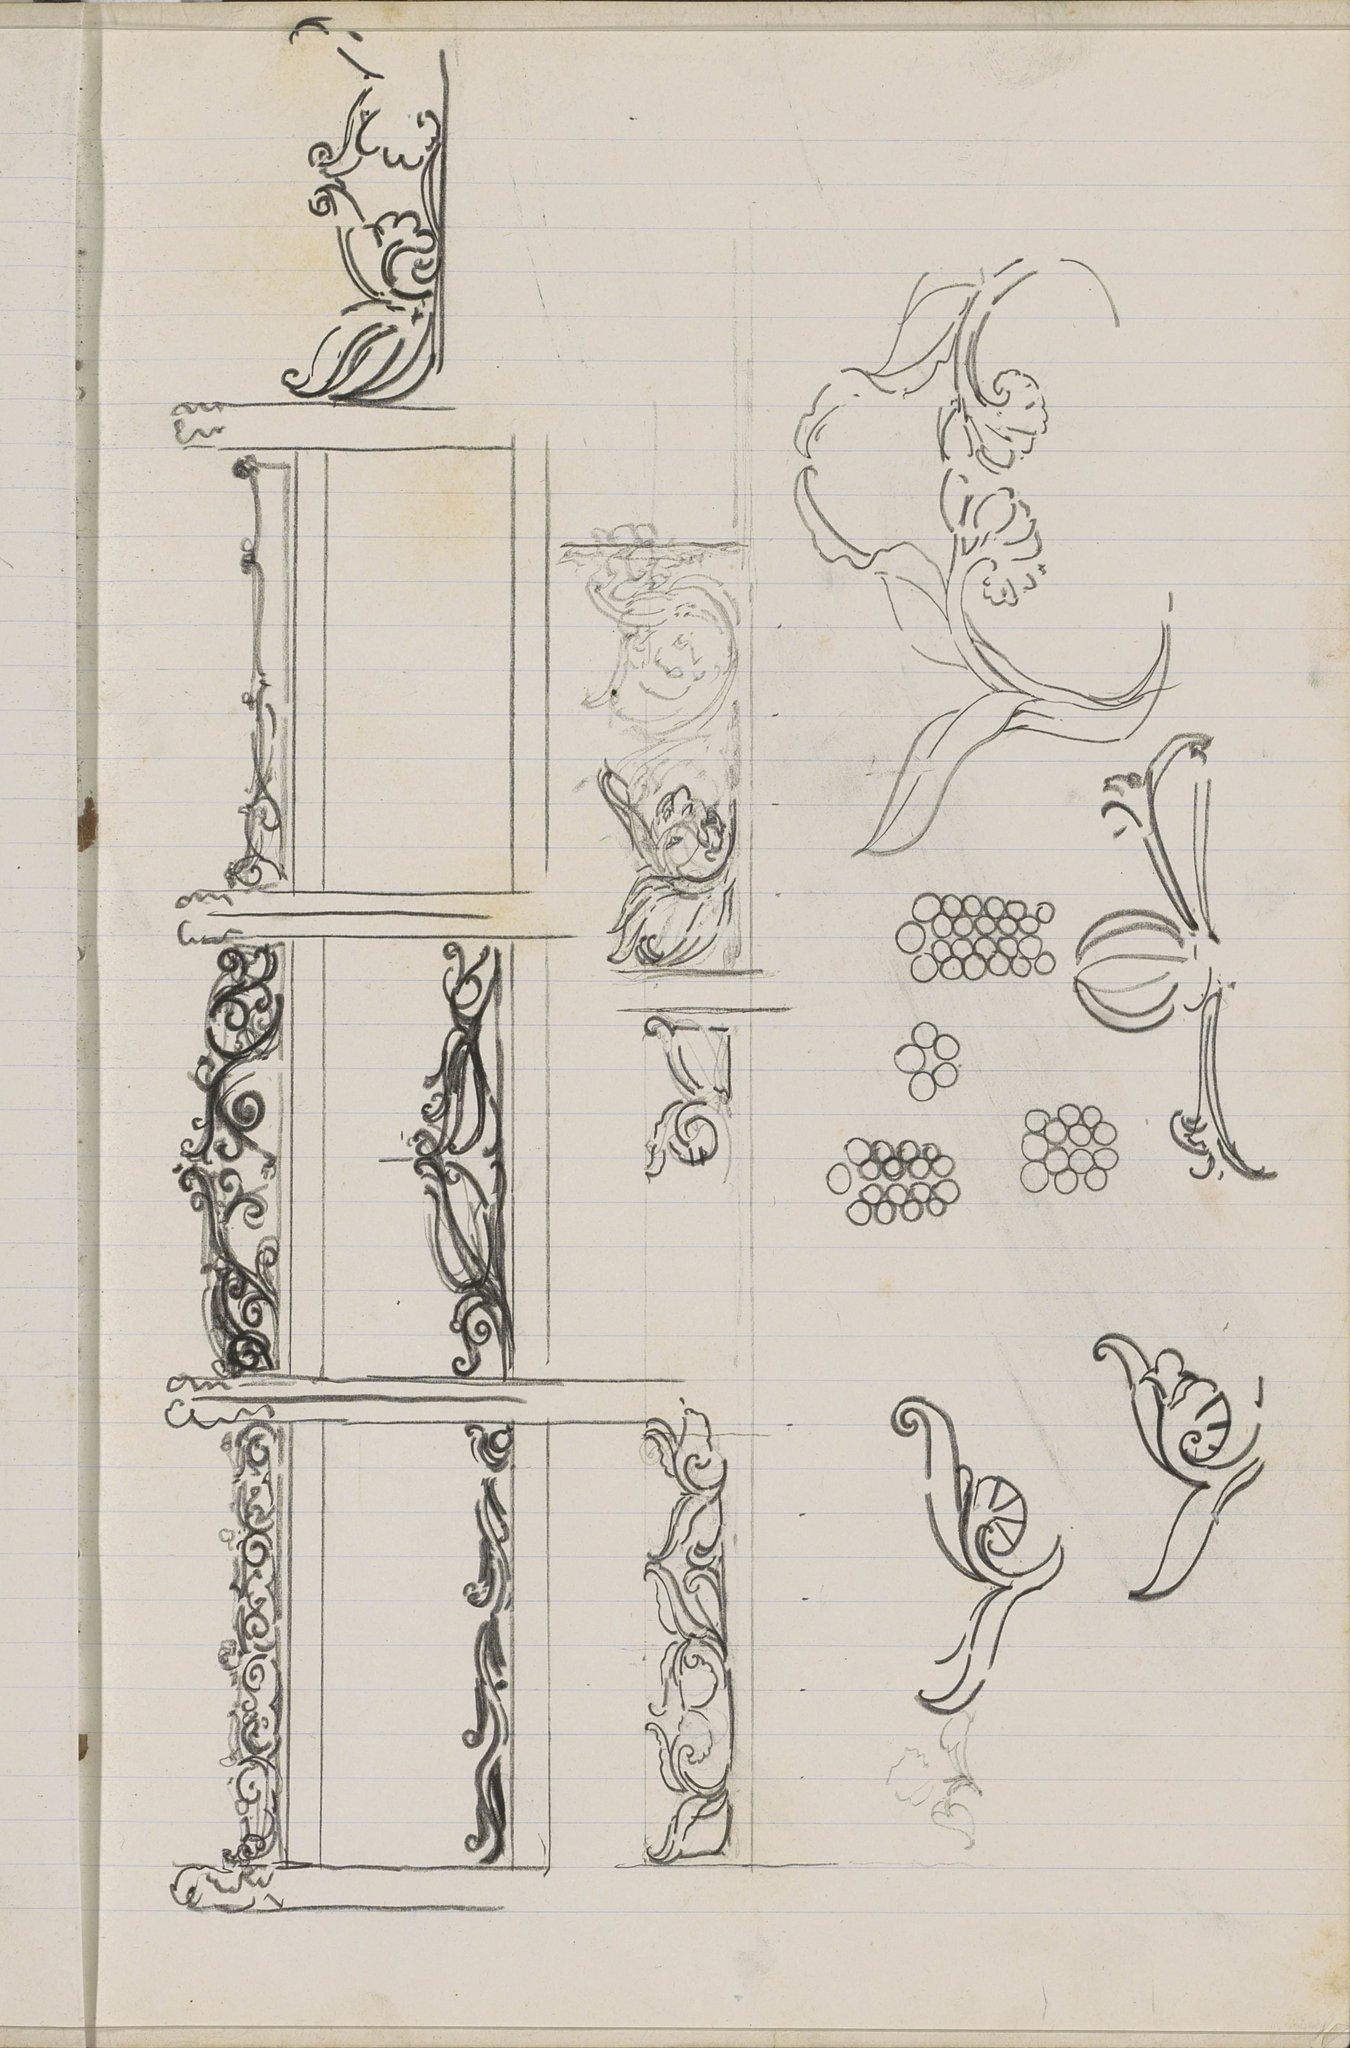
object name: sketchbook leaf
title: Florale ornamenten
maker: gerrit willem dijsselhof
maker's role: designer, draughtsman, print maker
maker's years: 1866-1924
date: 1901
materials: chalk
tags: flowers ~ ornament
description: Blad 60 recto uit een schetsboek met 79 bladen.